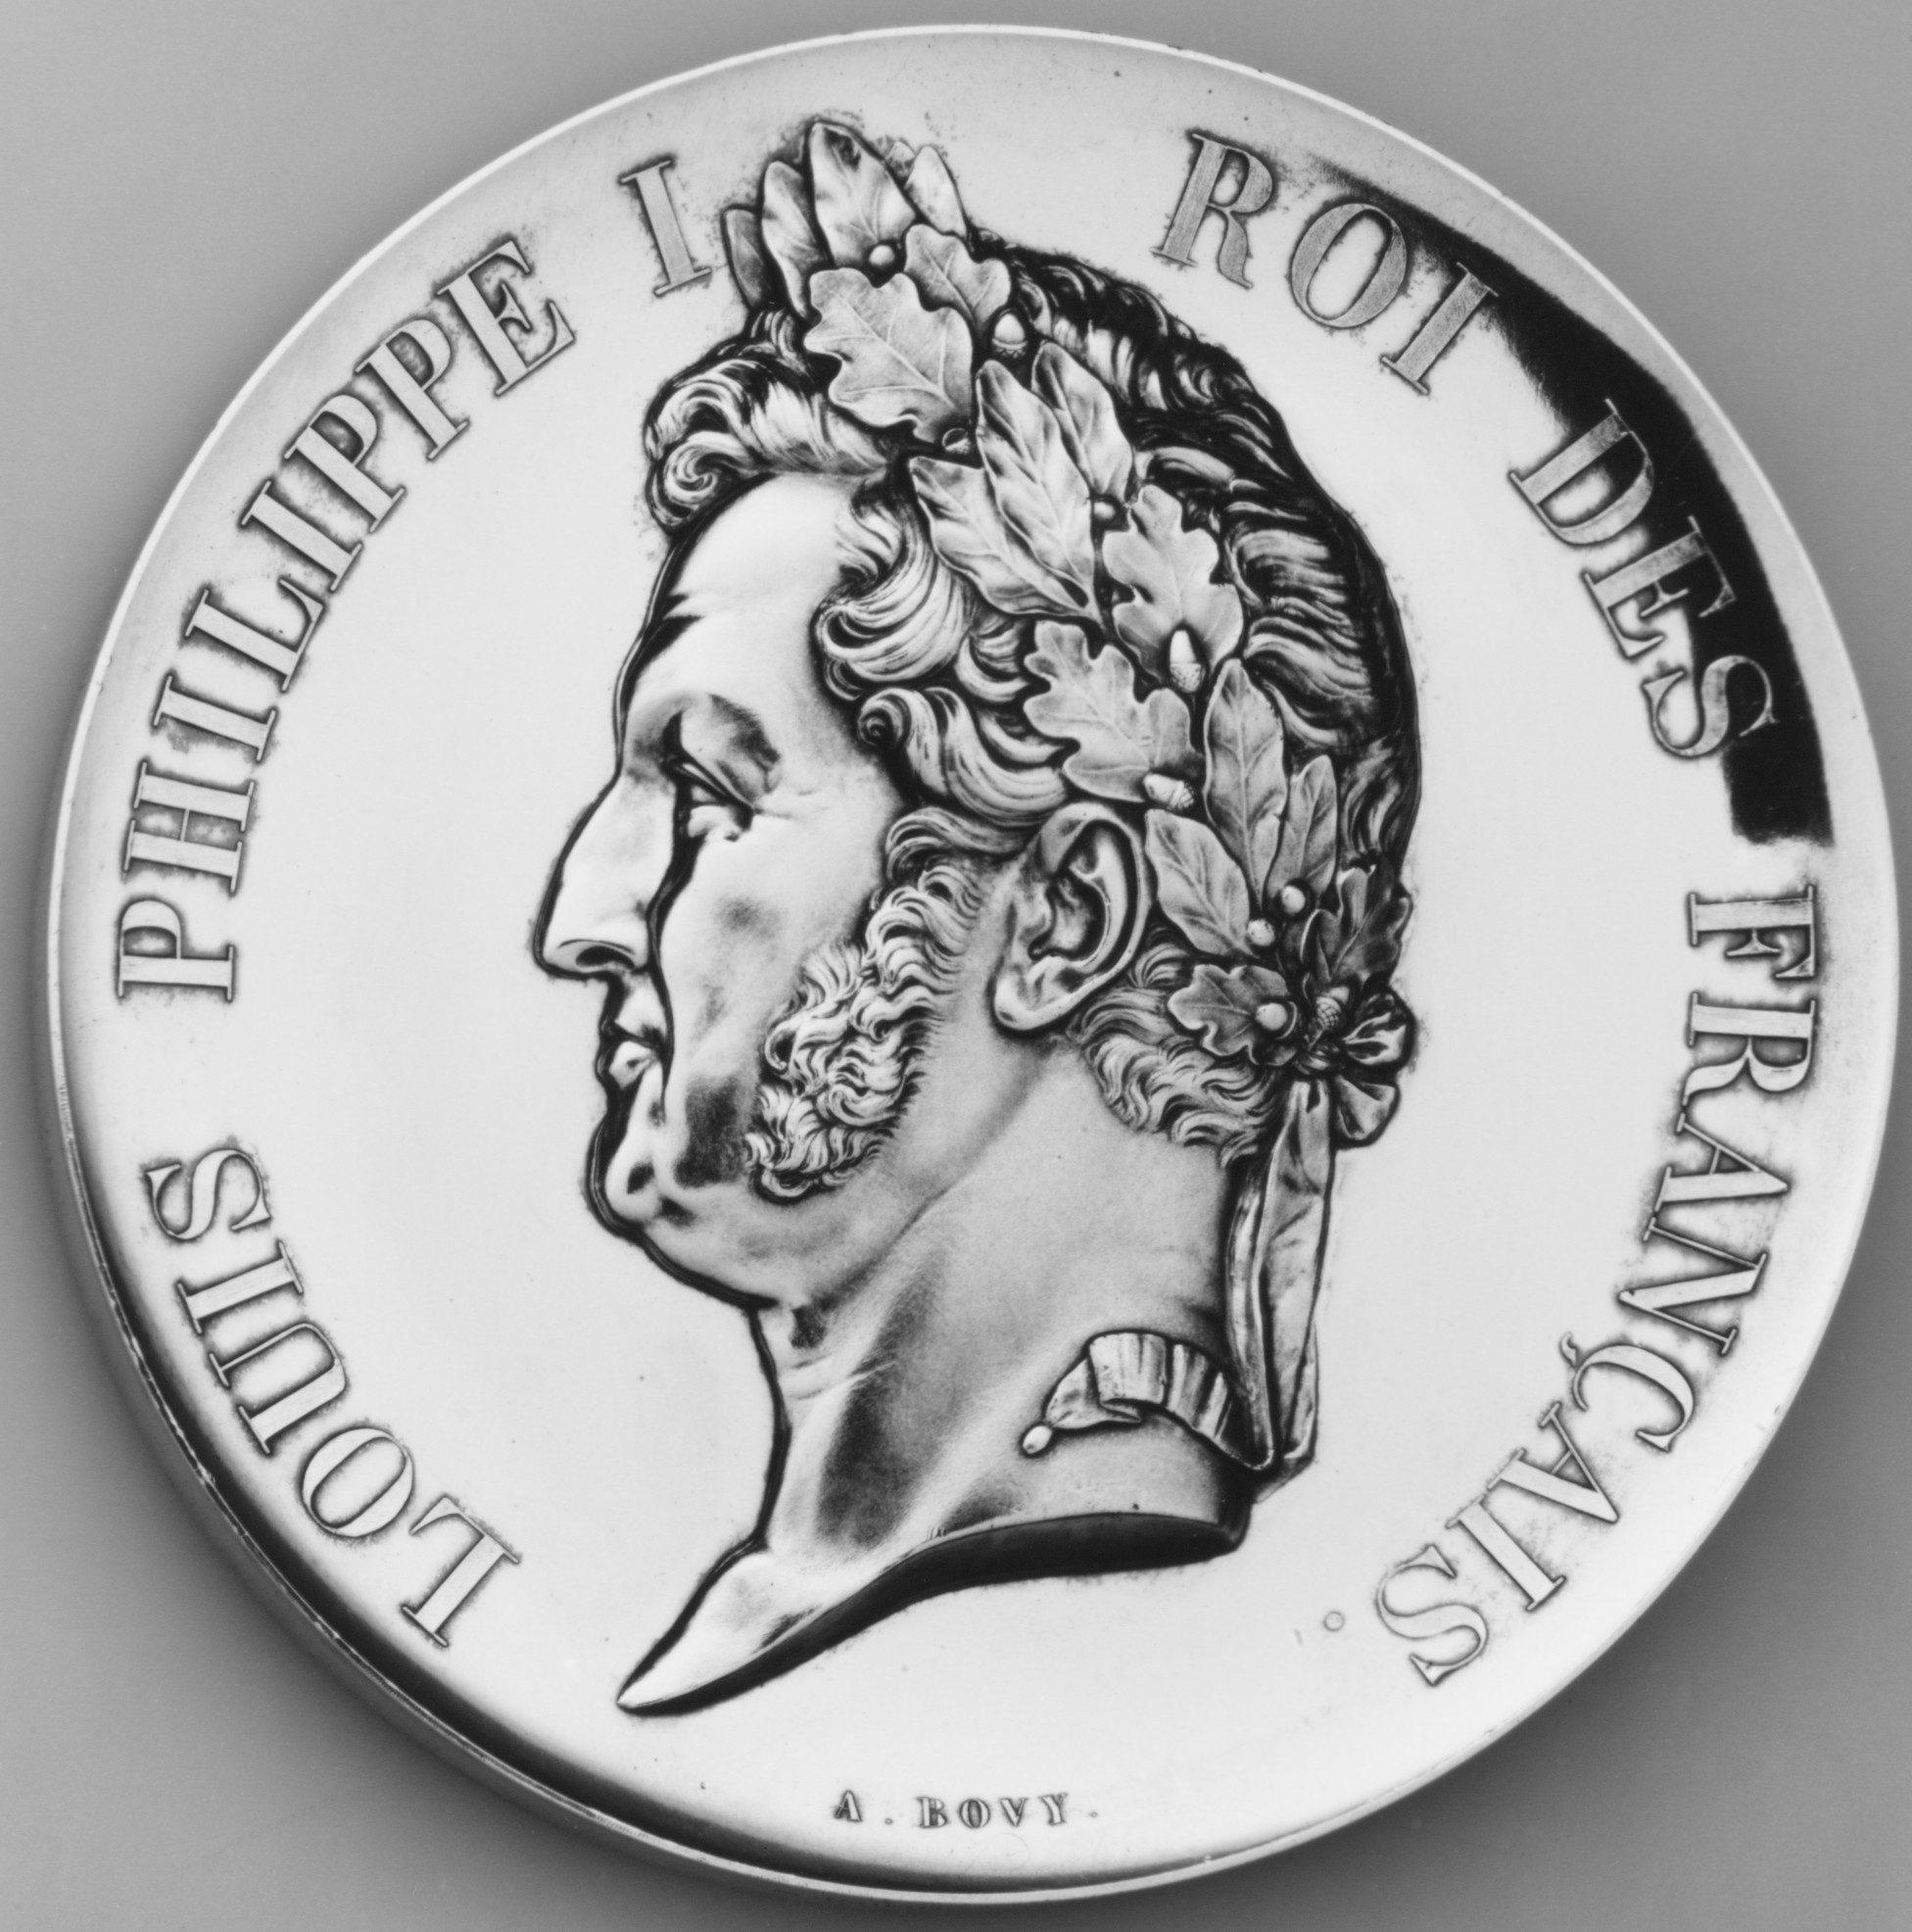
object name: medal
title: Louis-Philippe and Building of the French Railways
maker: jean-françois-antoine bovy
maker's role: artist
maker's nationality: french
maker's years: 1795-1877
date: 1842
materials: silver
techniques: struck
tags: men,profiles